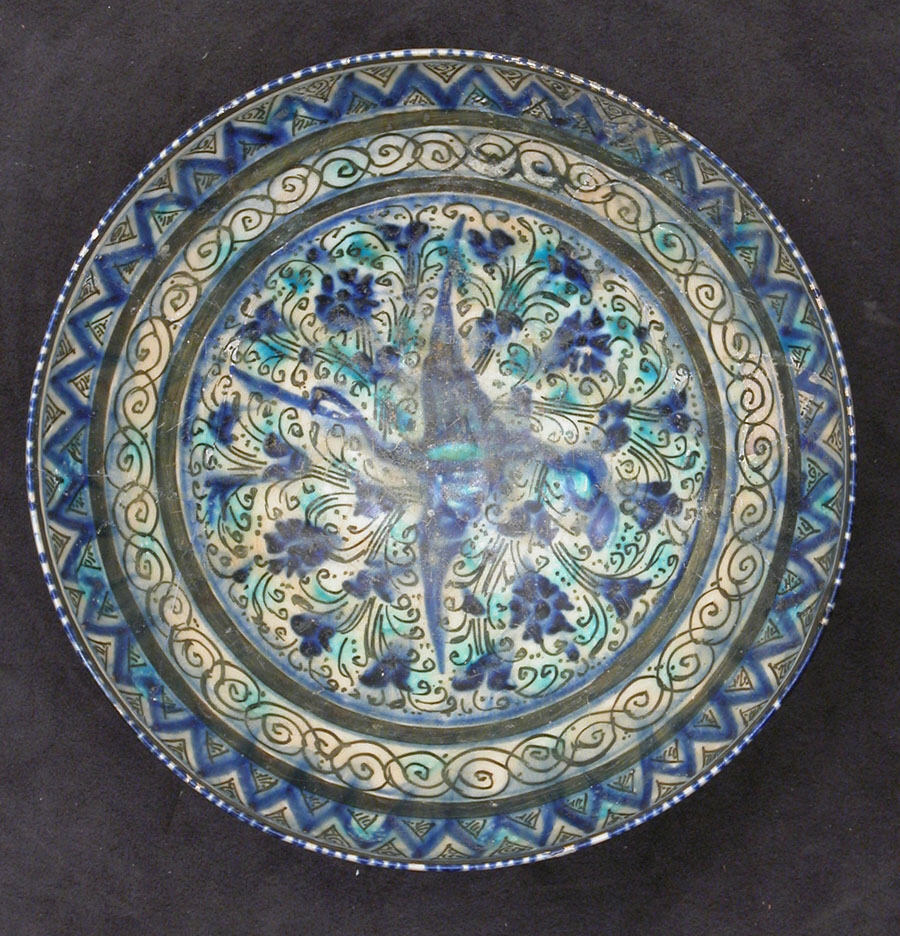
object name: bowl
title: Bowl with Flying Bird Design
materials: glaze, stonepaste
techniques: painting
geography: iran